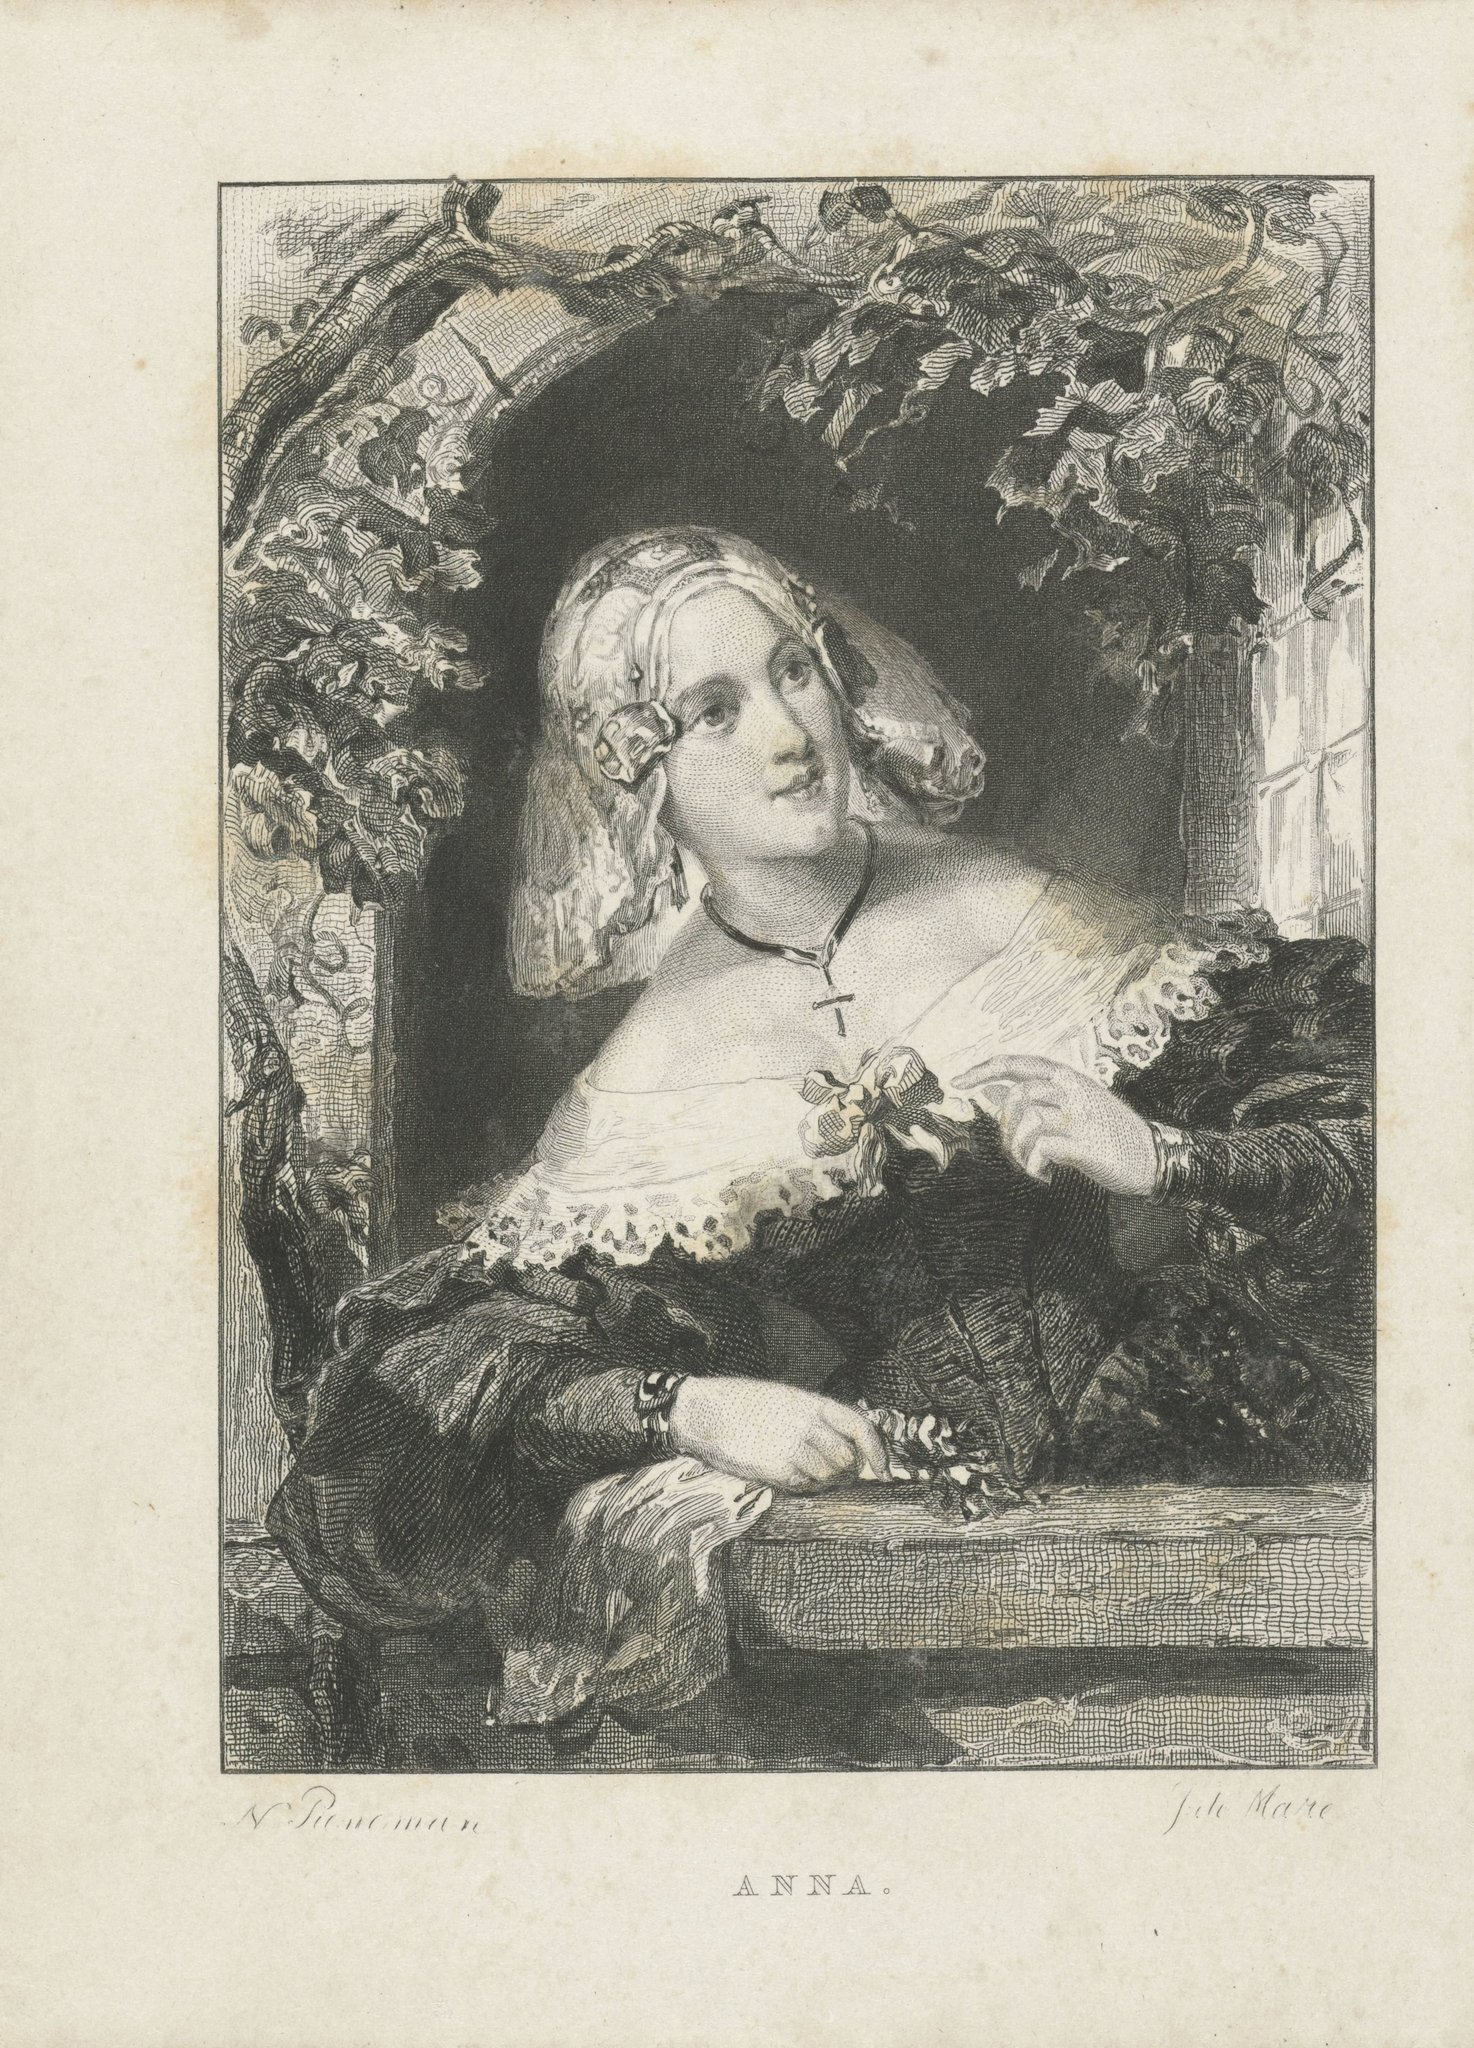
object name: print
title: Vrouw in een venster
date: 1839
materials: paper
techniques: engraving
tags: adolescent, young woman, maiden, open window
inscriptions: collector's mark: Lugt 2228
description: Prent gebruikt in: Tesselschade. Jaarboekje voor 1839. Amsterdam: Hendrik Frijlink, 1839.